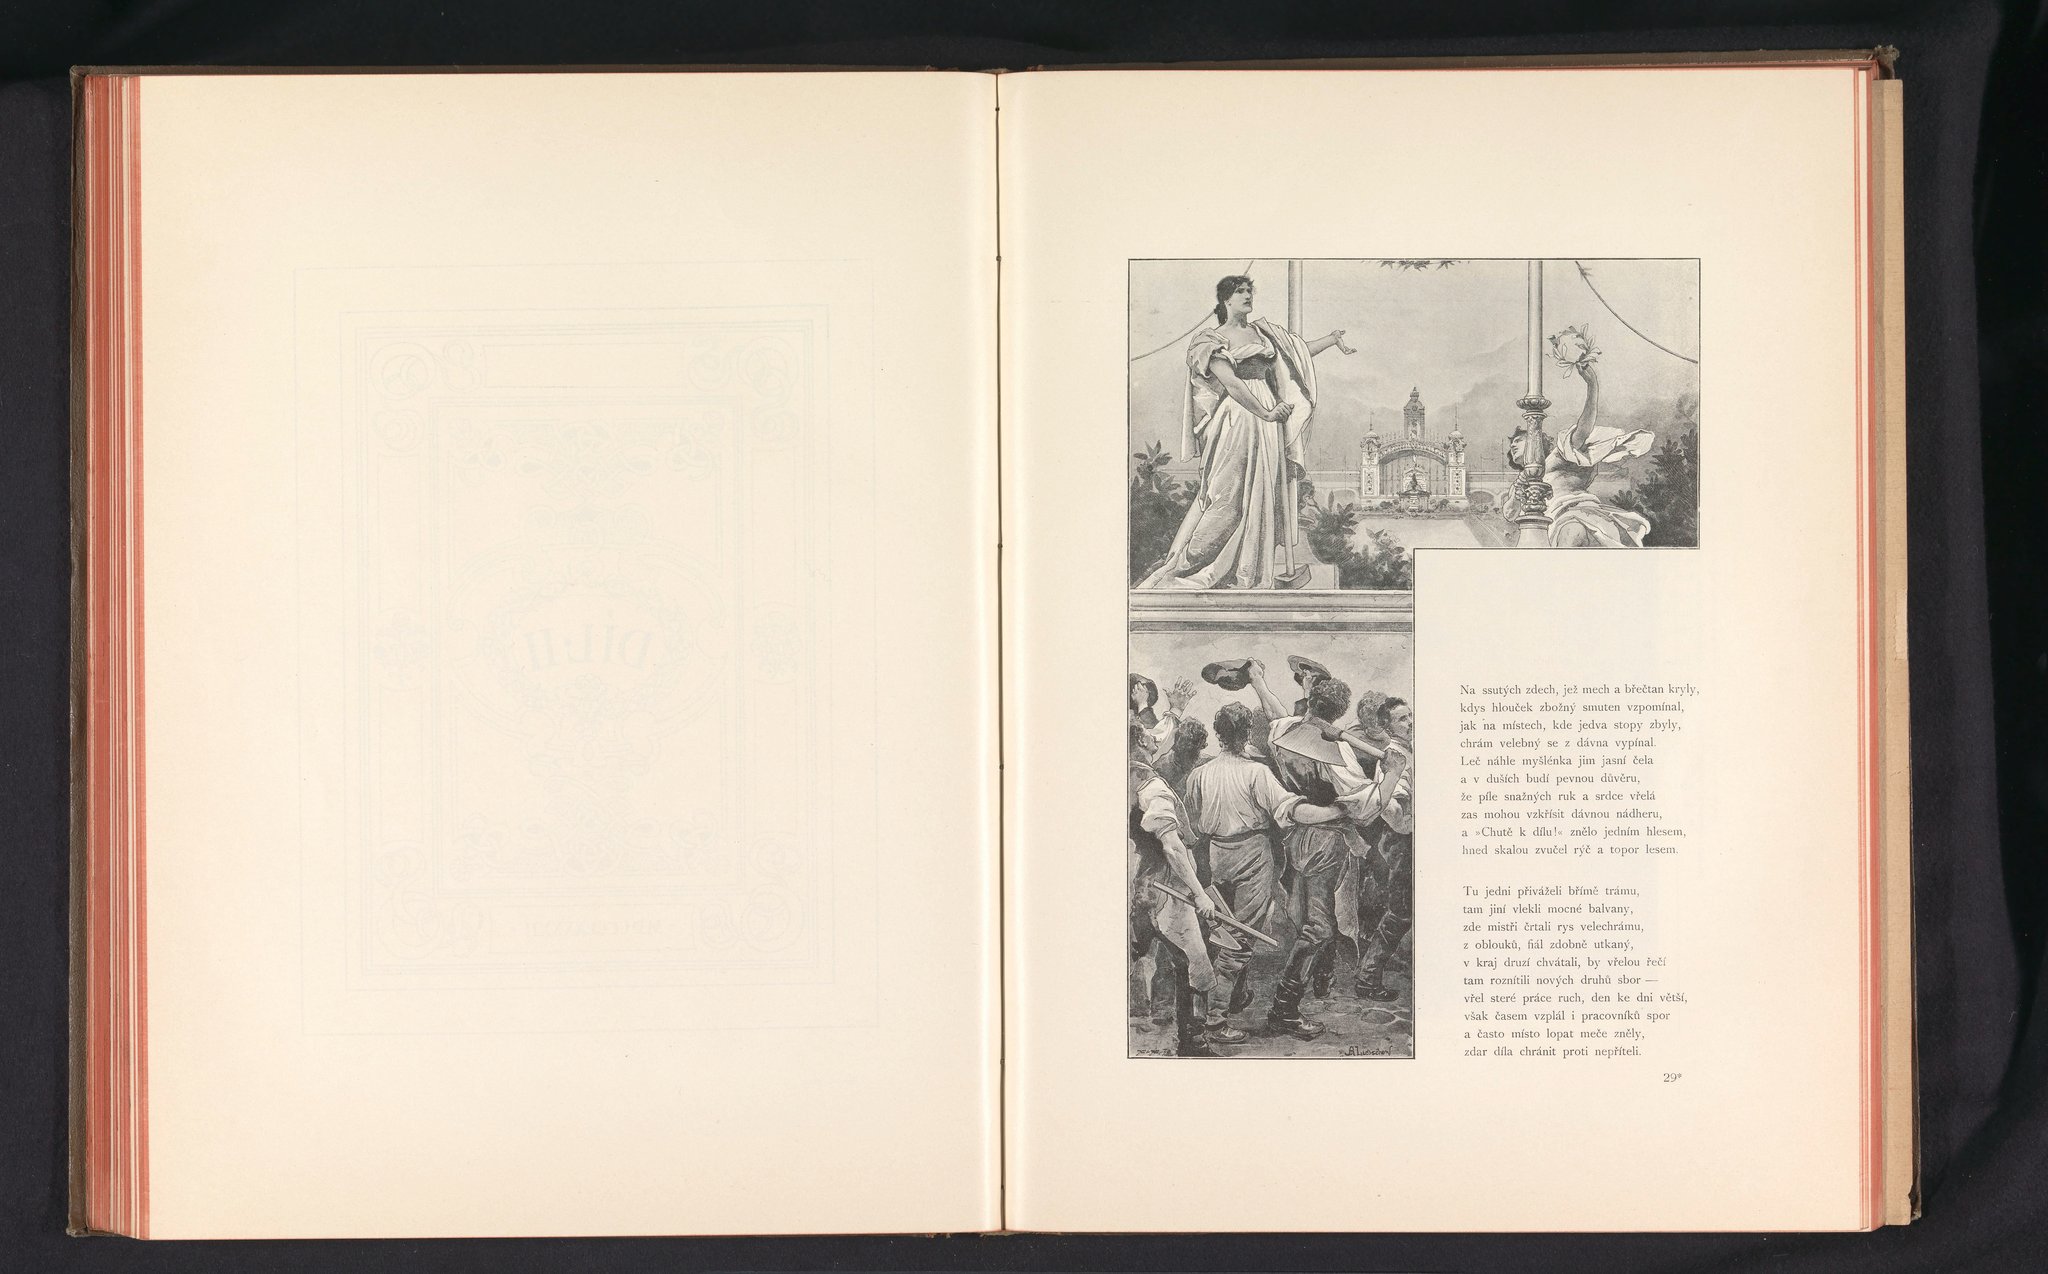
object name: page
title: Fotoreproductie van een tekening, voorstellende arbeiders salueren een vrouw met een hamer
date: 1888-1893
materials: paper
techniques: autotype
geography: výstaviště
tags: adult woman, working class, labourers